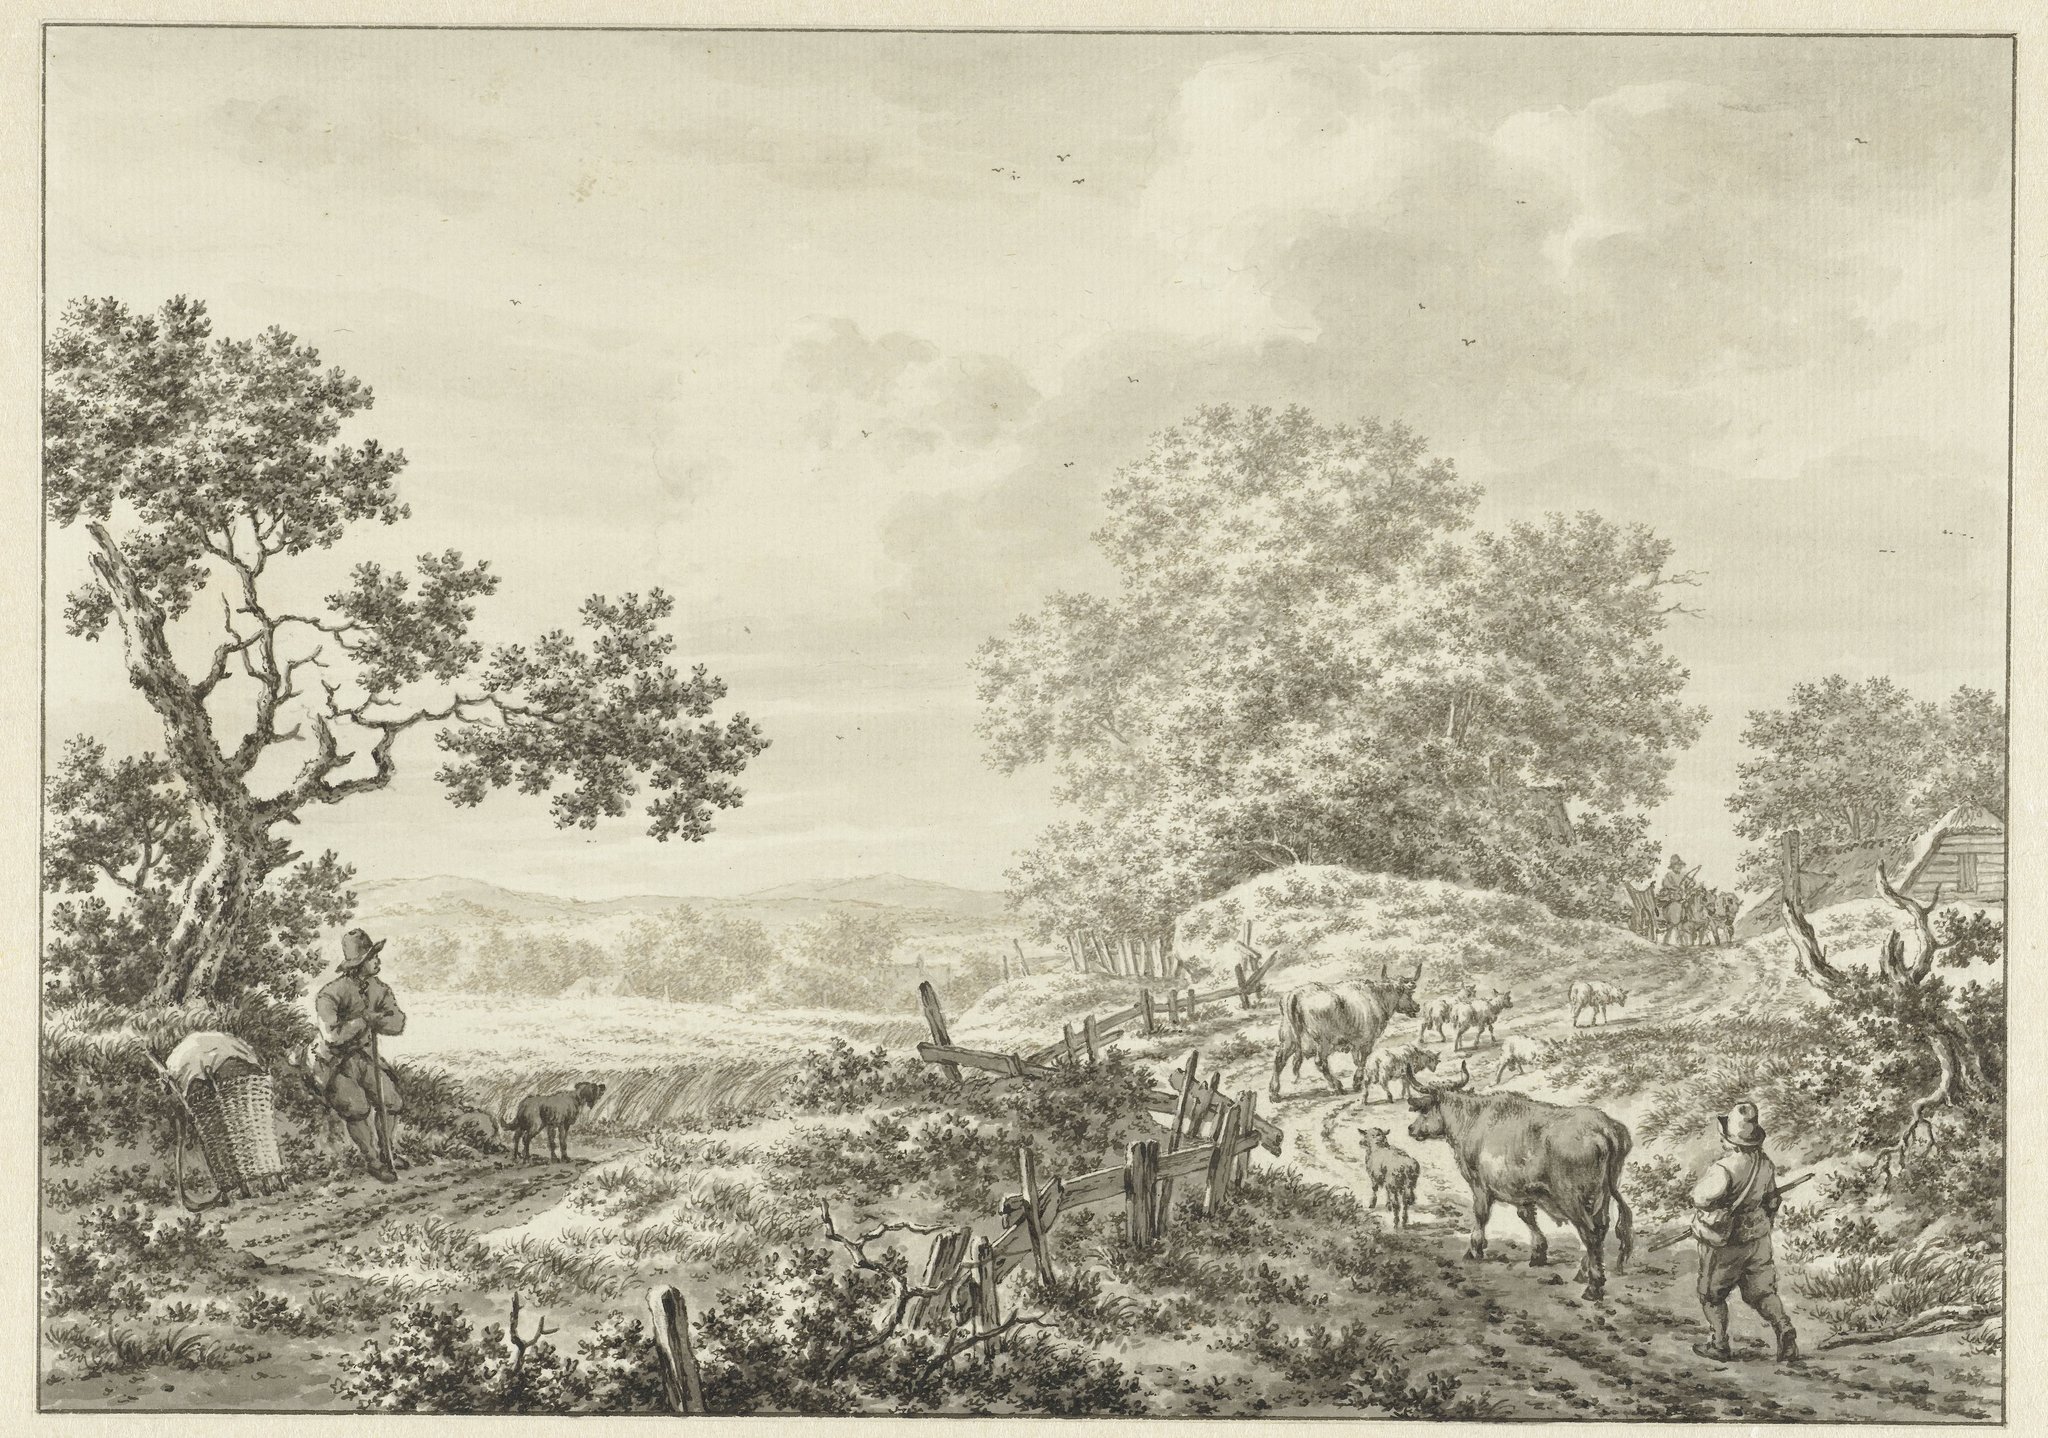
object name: drawing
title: Zomerlandschap met herder met twee koeien en schapen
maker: jacob cats (1741-1799)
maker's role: draughtsman, print maker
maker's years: 1741-1799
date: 1751-1799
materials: ink, paper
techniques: brush, pen